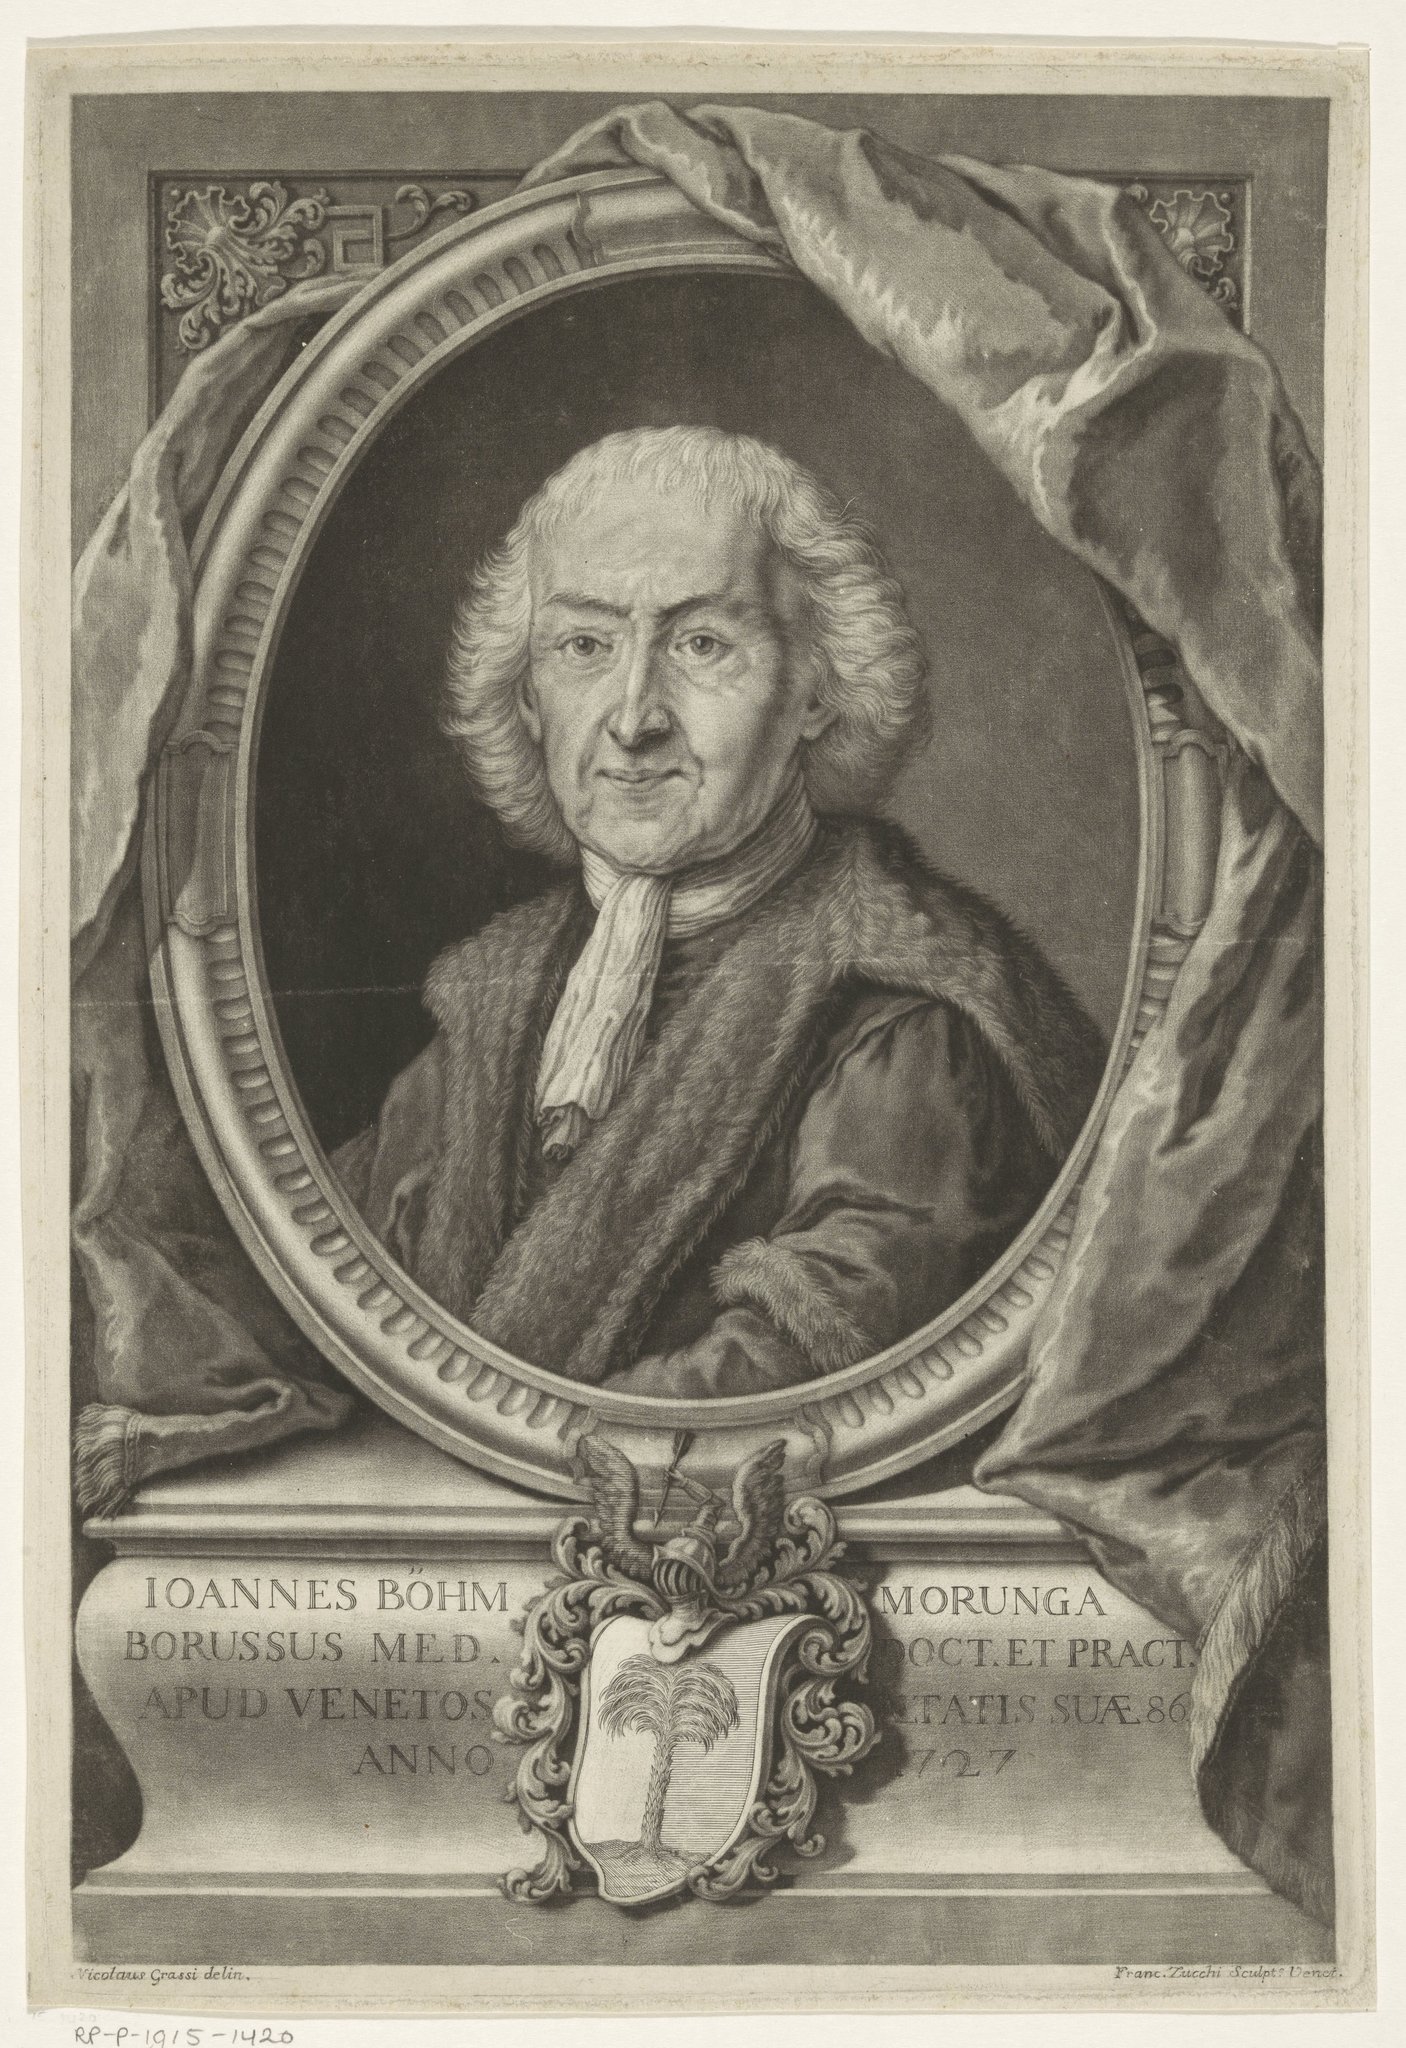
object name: print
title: Portret van medicus Johann Böhm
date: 1727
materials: paper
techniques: mezzotint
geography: venice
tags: johann böhm, historical persons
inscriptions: collector's mark: Lugt 2228